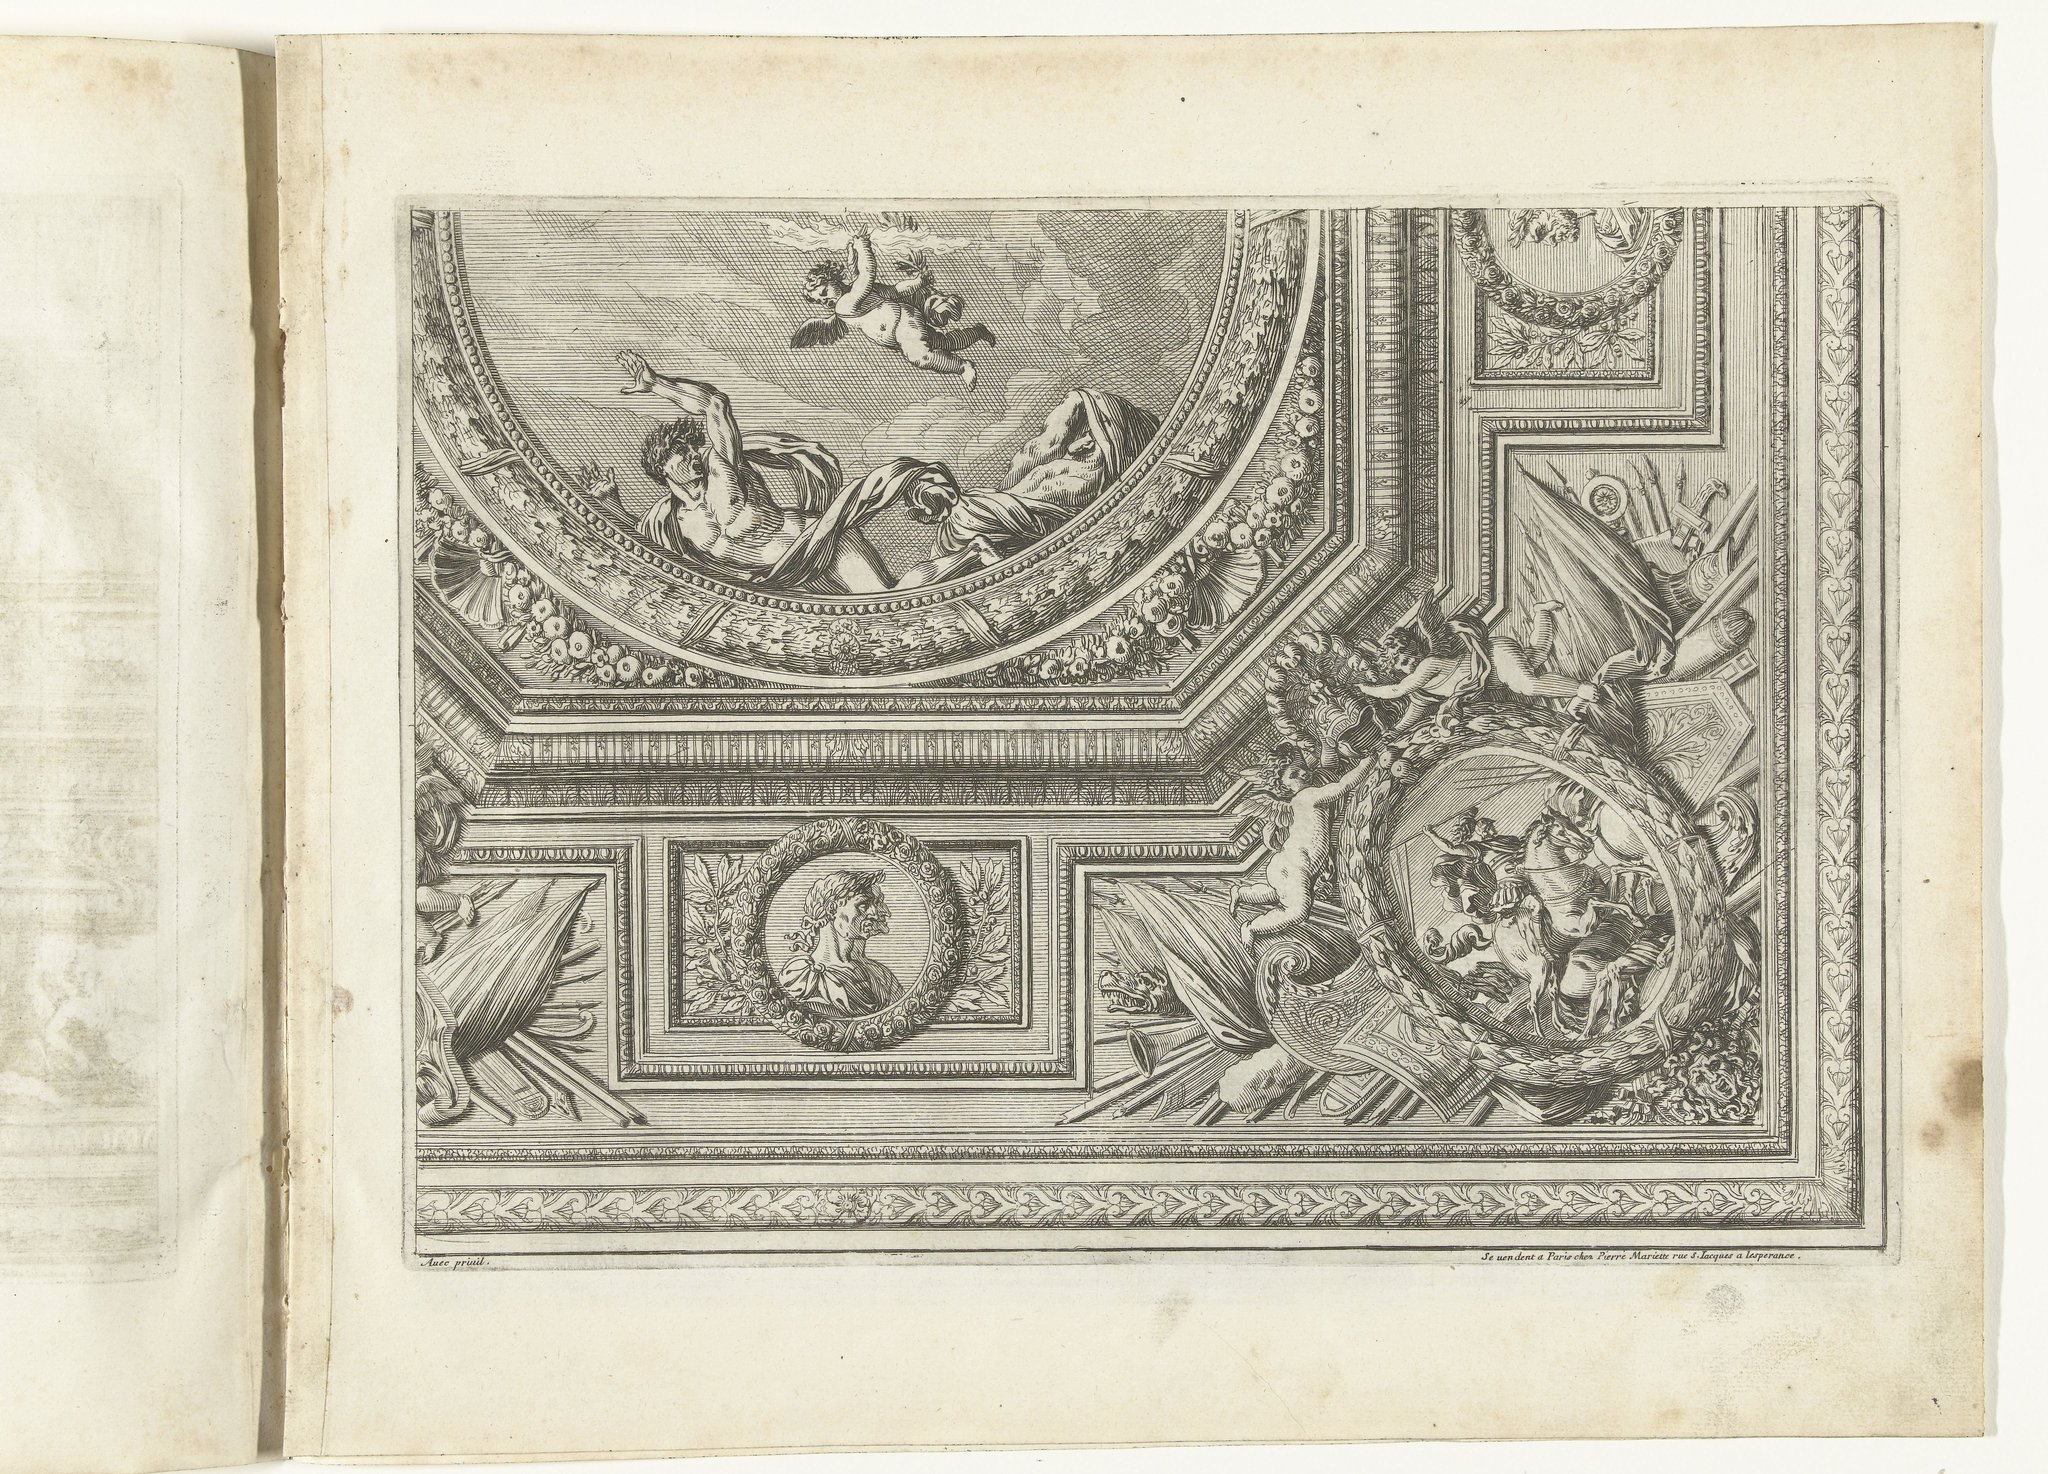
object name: print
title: Grands Carts de Plafons a la Romaine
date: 1661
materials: paper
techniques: etching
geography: paris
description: In het midden een putto als Jupiter; de rand is gedecoreerd met keizerbustes in medaillons en in de hoek een ovaal medaillon met een gevechtsscène. Blad uit serie van 6 bladen met grote kwarten van plafonds in klassieke stijl, sommige met varianten voor de randen. Uit eerste editie.